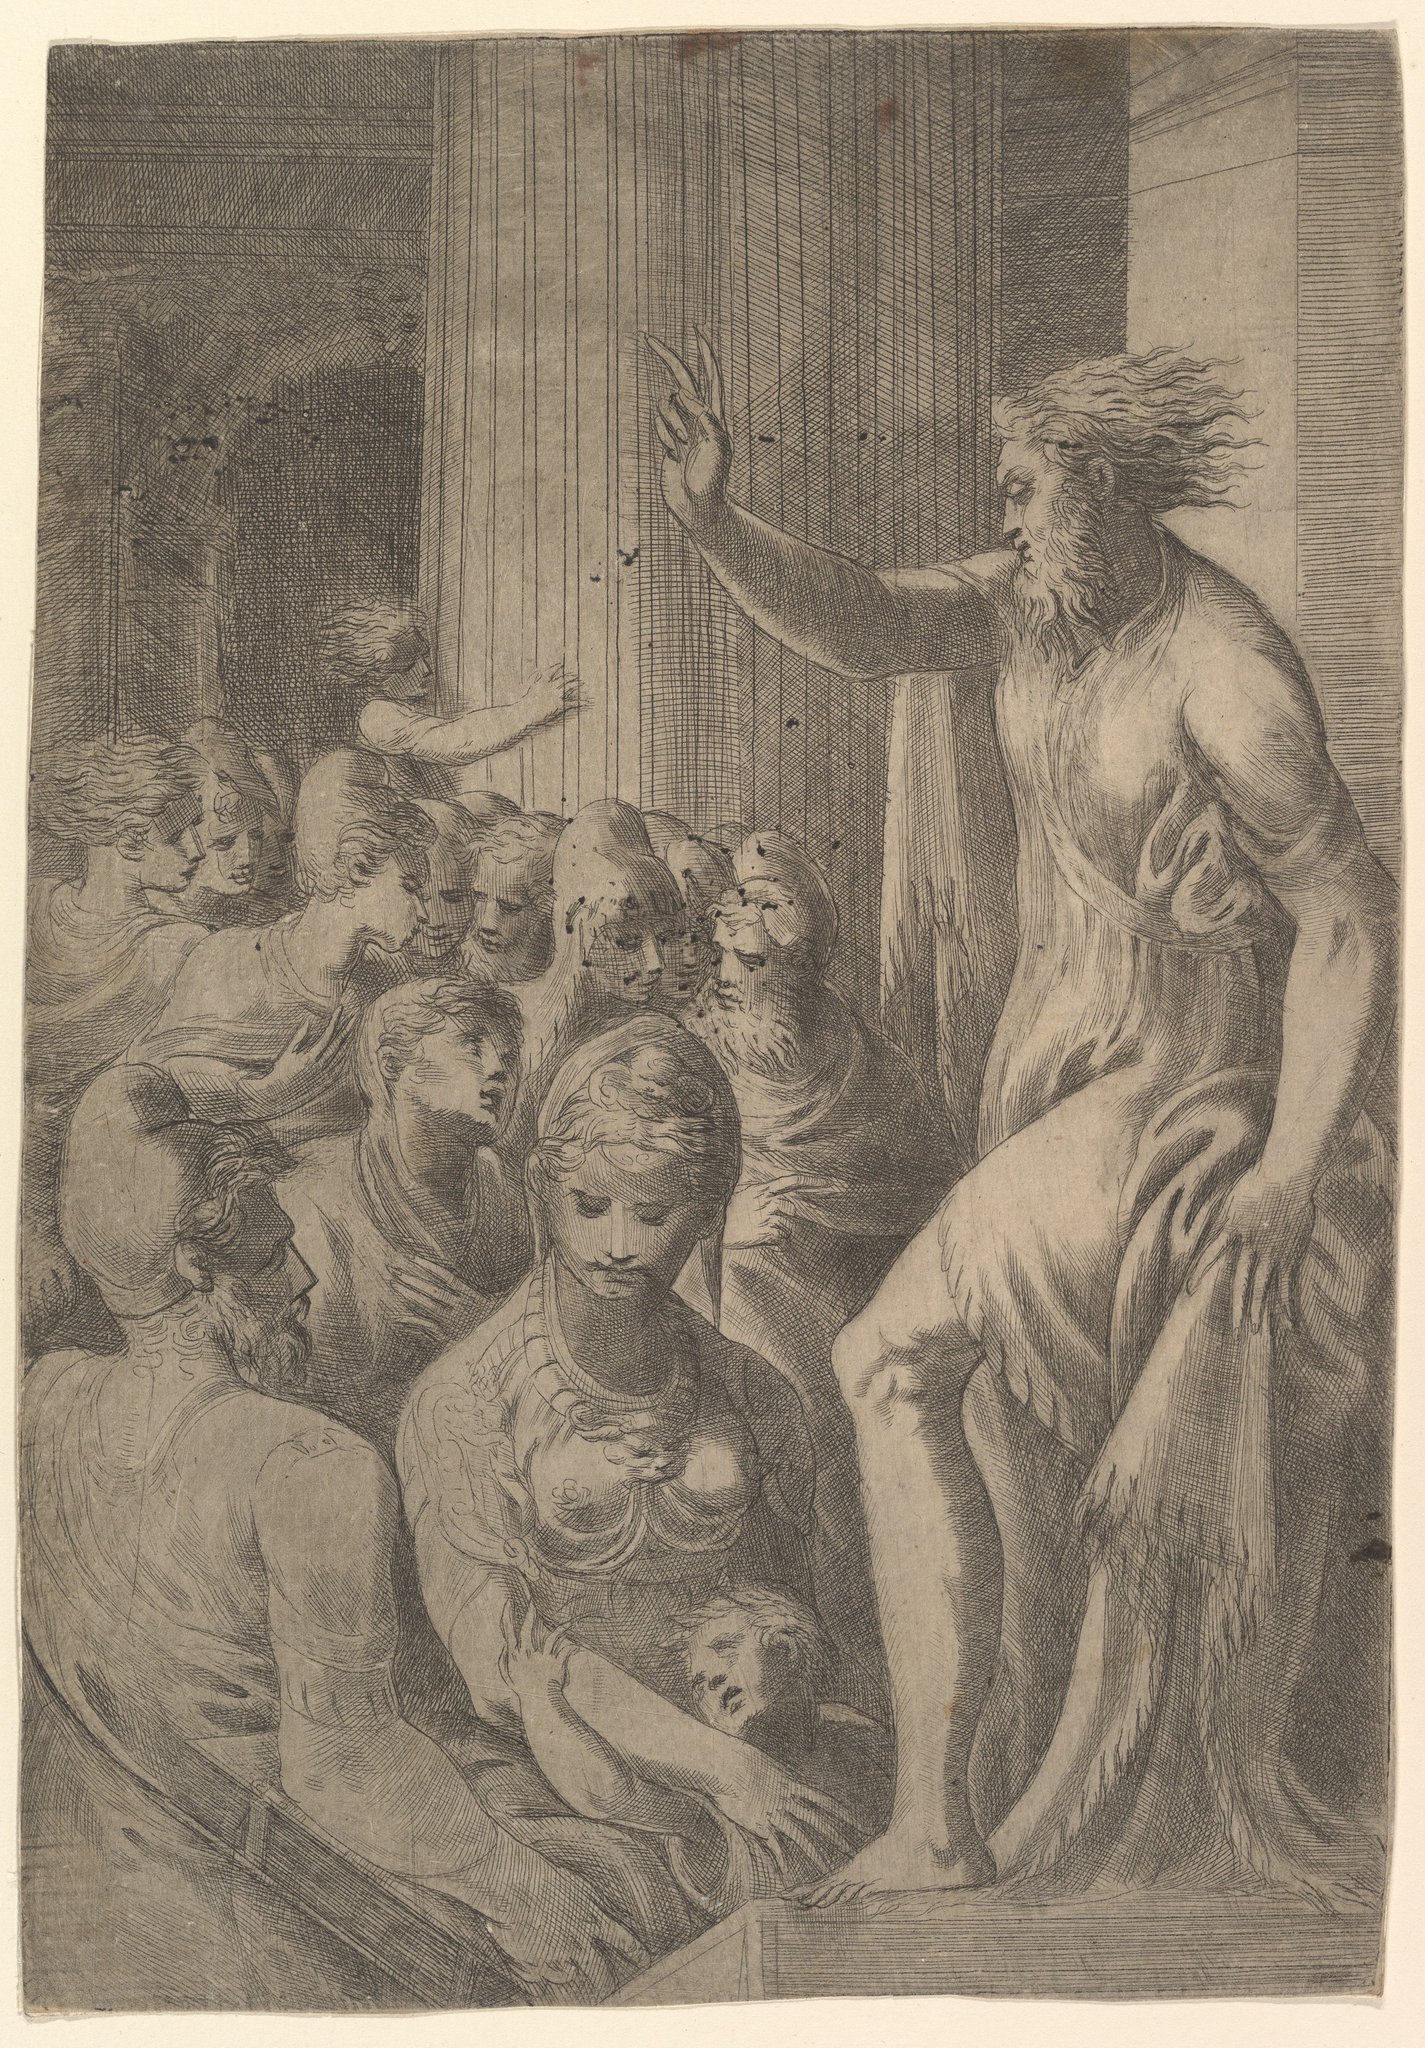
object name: print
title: Saint Paul preaching in Athens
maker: andrea schiavone (andrea meldola)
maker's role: artist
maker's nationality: italian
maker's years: 1510-1563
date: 1548-1553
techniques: etching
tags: boys,men,women,saint paul